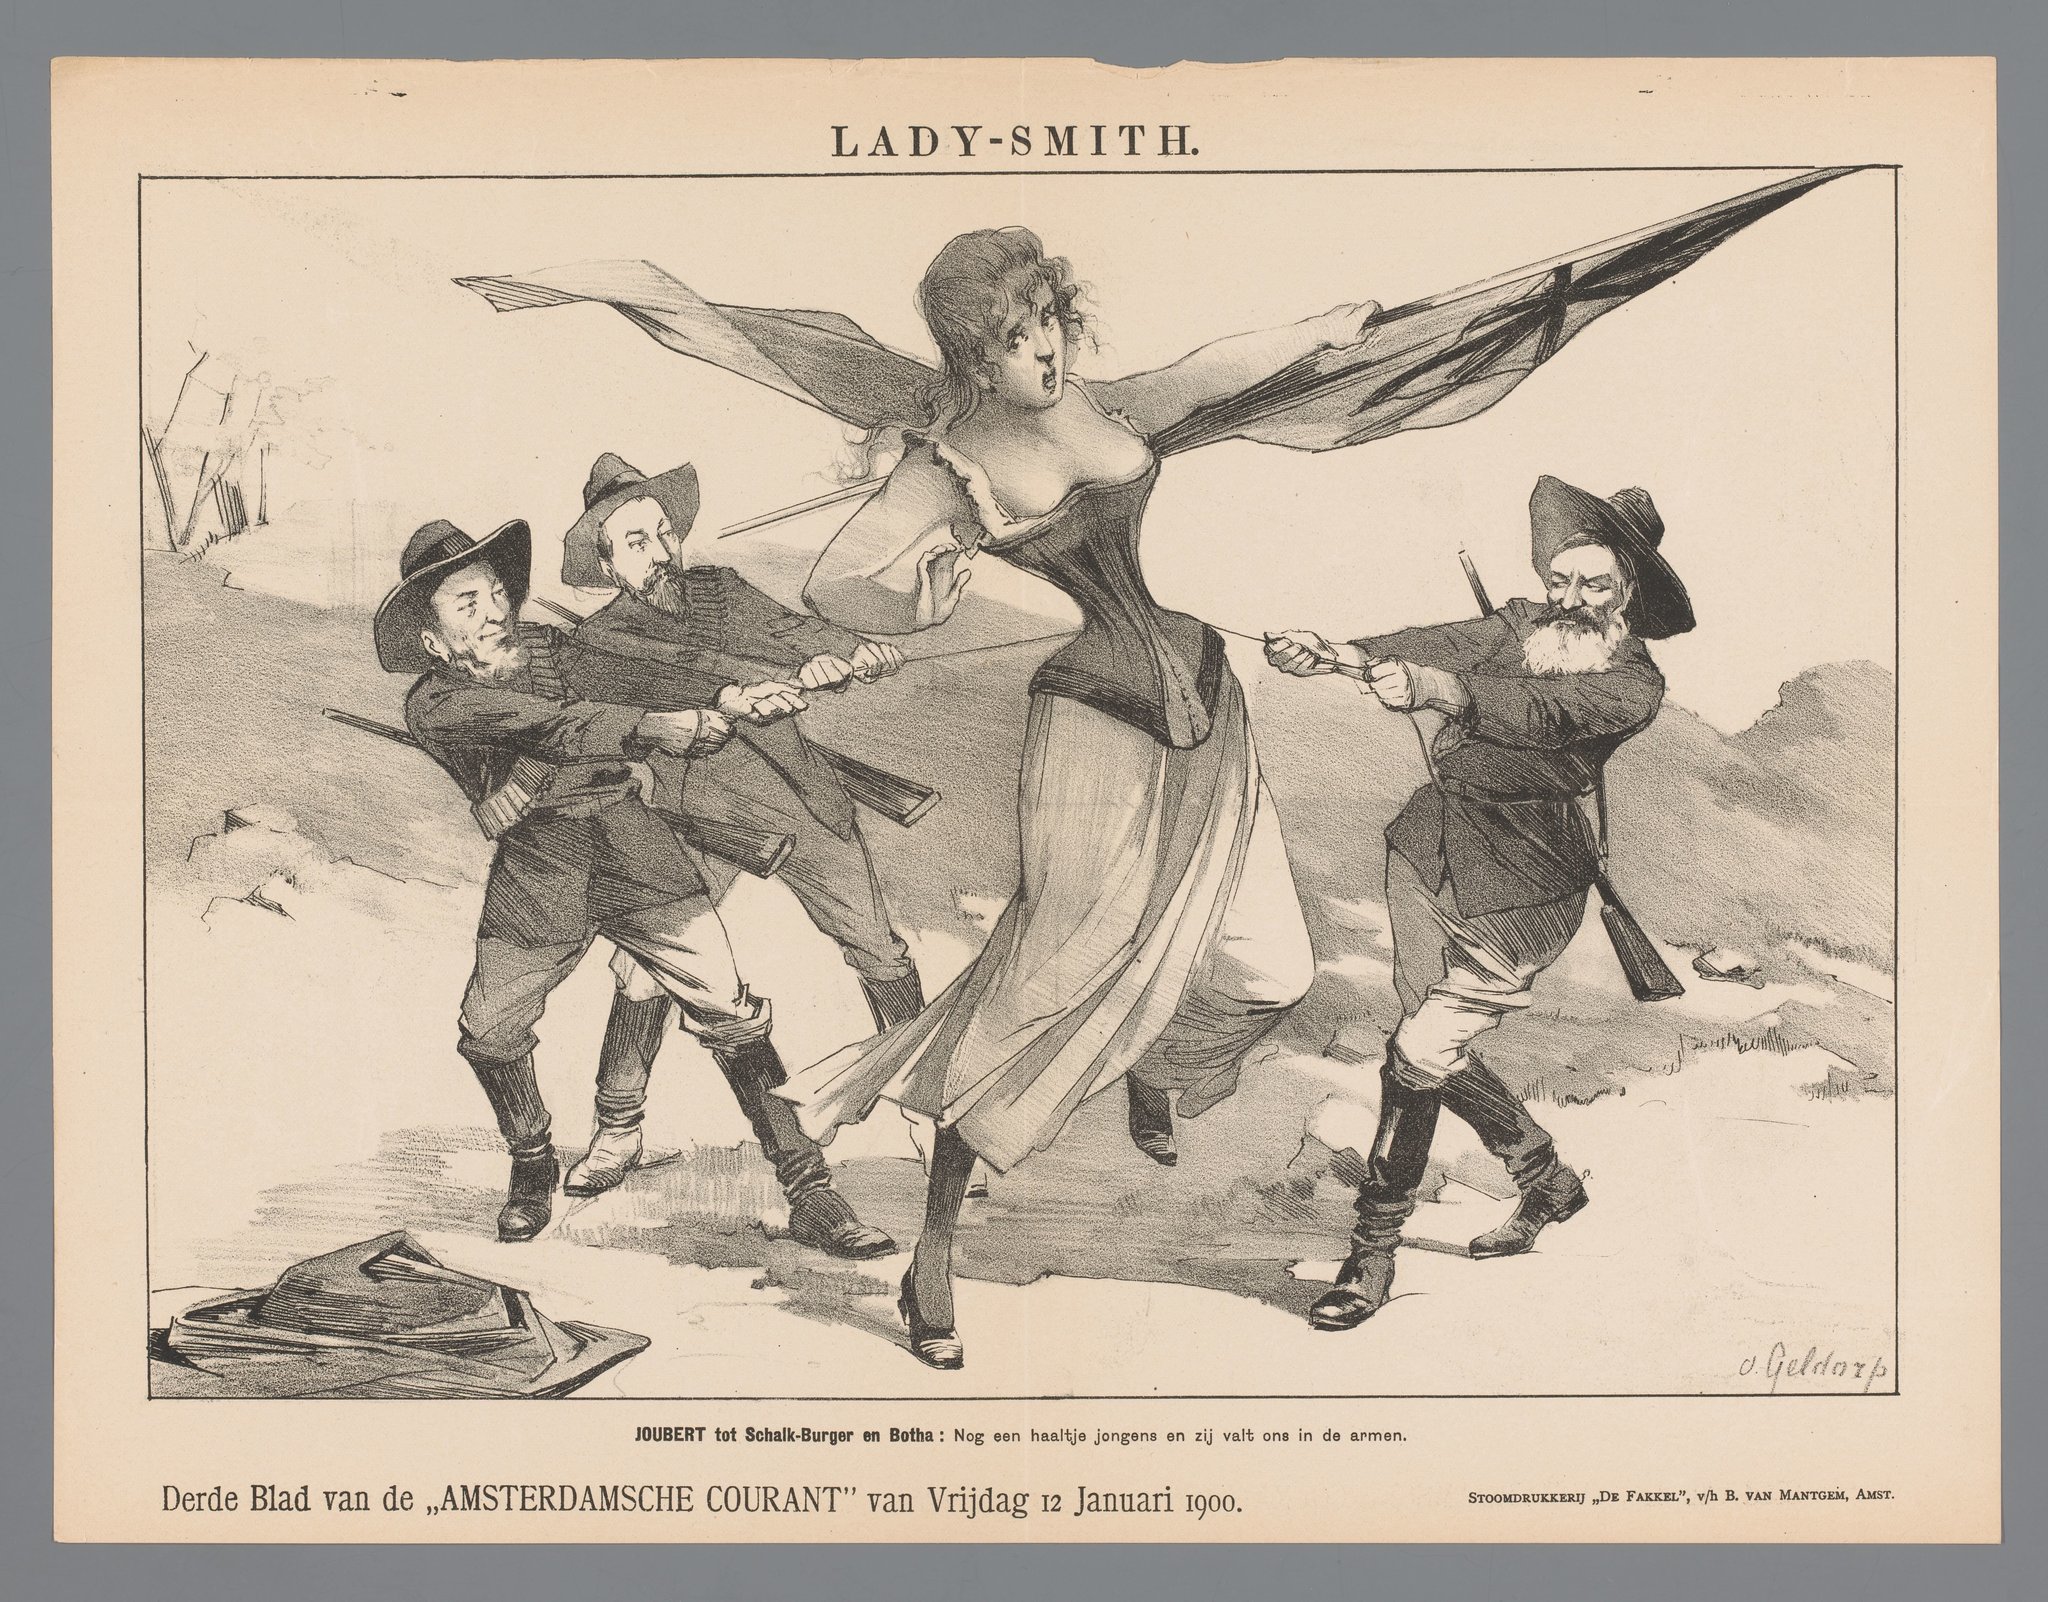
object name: cartoon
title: Lady-Smith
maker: petrus van geldorp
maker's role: draughtsman, print maker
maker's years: 1872-1939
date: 1900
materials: paper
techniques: lithograph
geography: amsterdam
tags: politician, lacing up a corset, historical persons, political caricatures and satires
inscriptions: date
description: Prent uit het bijvoegsel van: De Amsterdamsche Courant, 12 januari 1900.